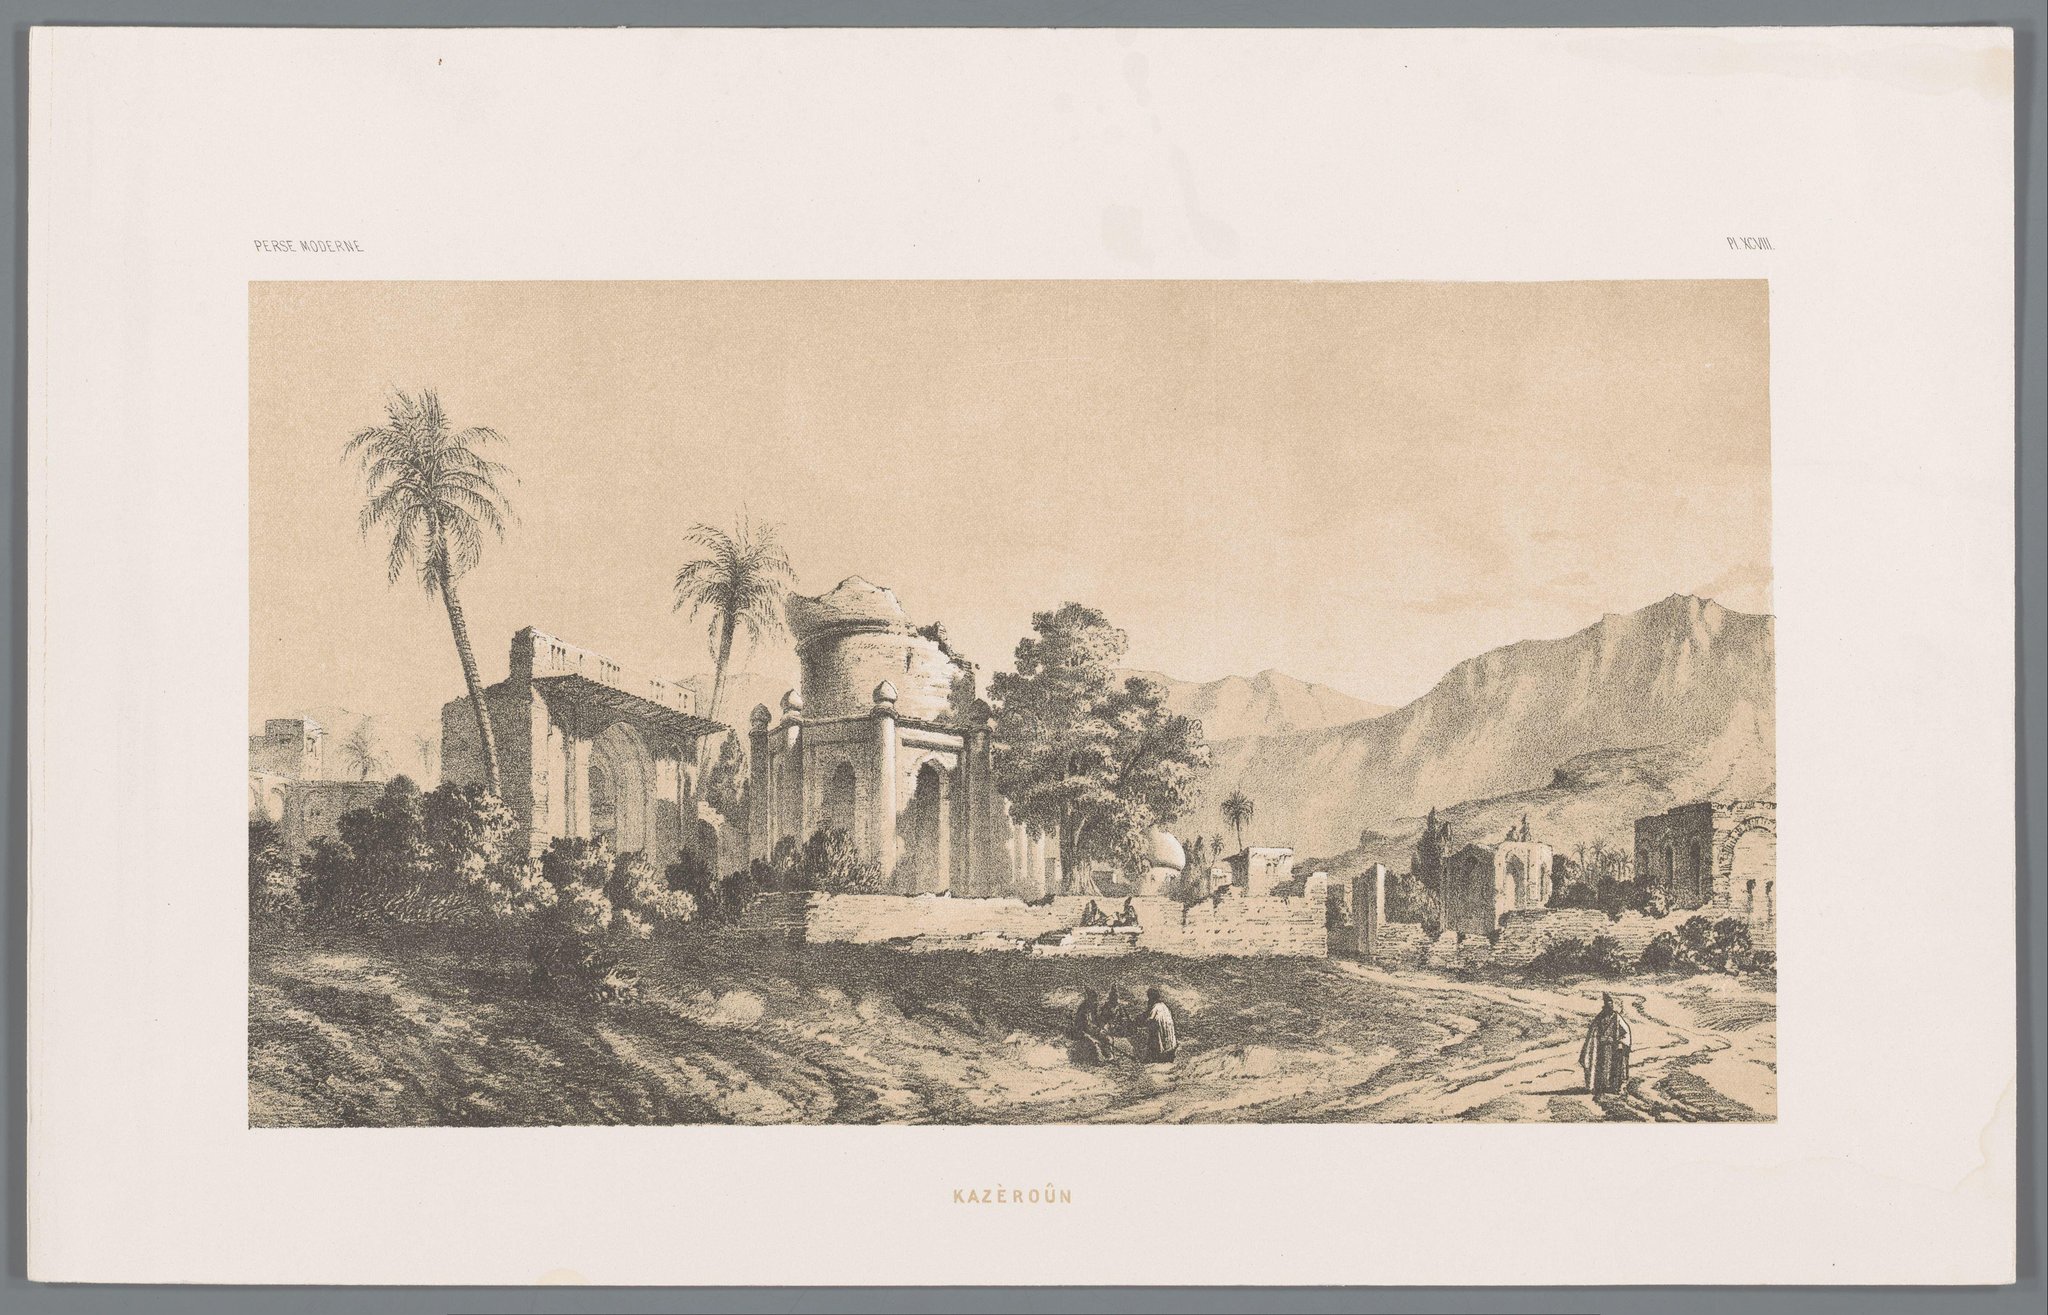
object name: print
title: Perzische landschappen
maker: eugène flandin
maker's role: painter, print maker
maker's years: 1809-1889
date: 1843-1854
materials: paper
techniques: tone lithography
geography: paris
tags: landscape with ruins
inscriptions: collector's mark: Lugt 2228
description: Prent uit: Coste, Pascal-Xavier en Eugène Napoléon Flandin. Voyage en Perse de mm. Eugène Flandin, peintre, et Pascal Coste, architecte (...). 8 dln. Parijs: Gide et Jules Baudry, 1843-1854.